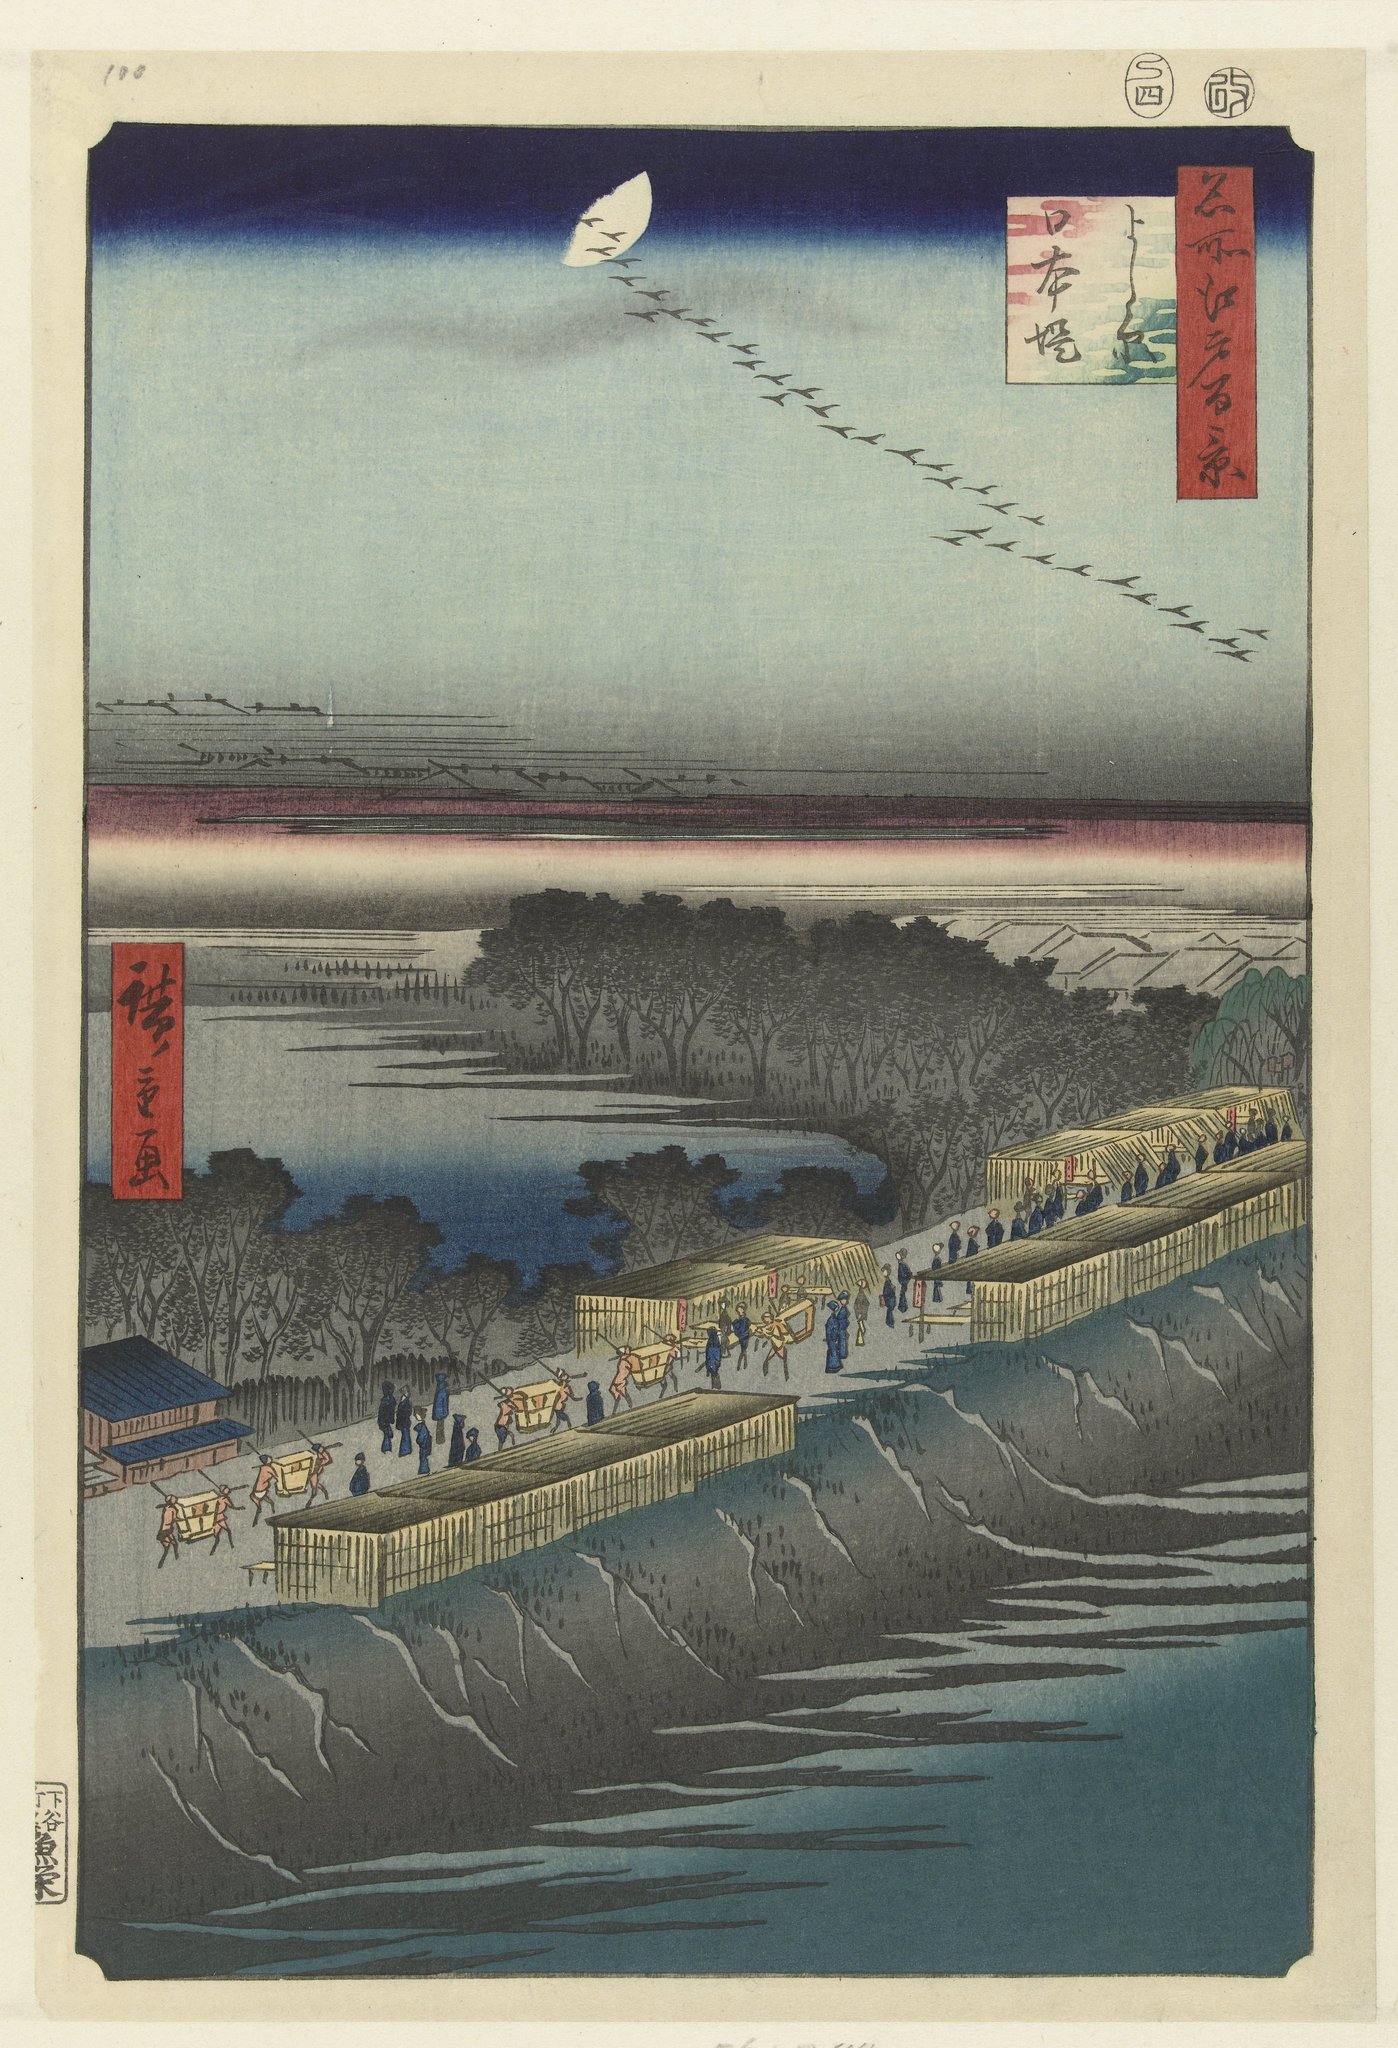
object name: print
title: Yoshiwara Nihonzutsumi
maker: utagawa hiroshige (i)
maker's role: draughtsman, print maker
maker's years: 1797-1858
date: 1804-1857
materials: paper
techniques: woodcut, nishiki e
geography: tokyo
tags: dikes, levee (+ landscape with figures, staffage)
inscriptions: date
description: Gezicht op de drukke weg over de dijk die naar het Yoshiwara, de plezierwijk van Edo, leidde. Langs de maan een vlucht ganzen.